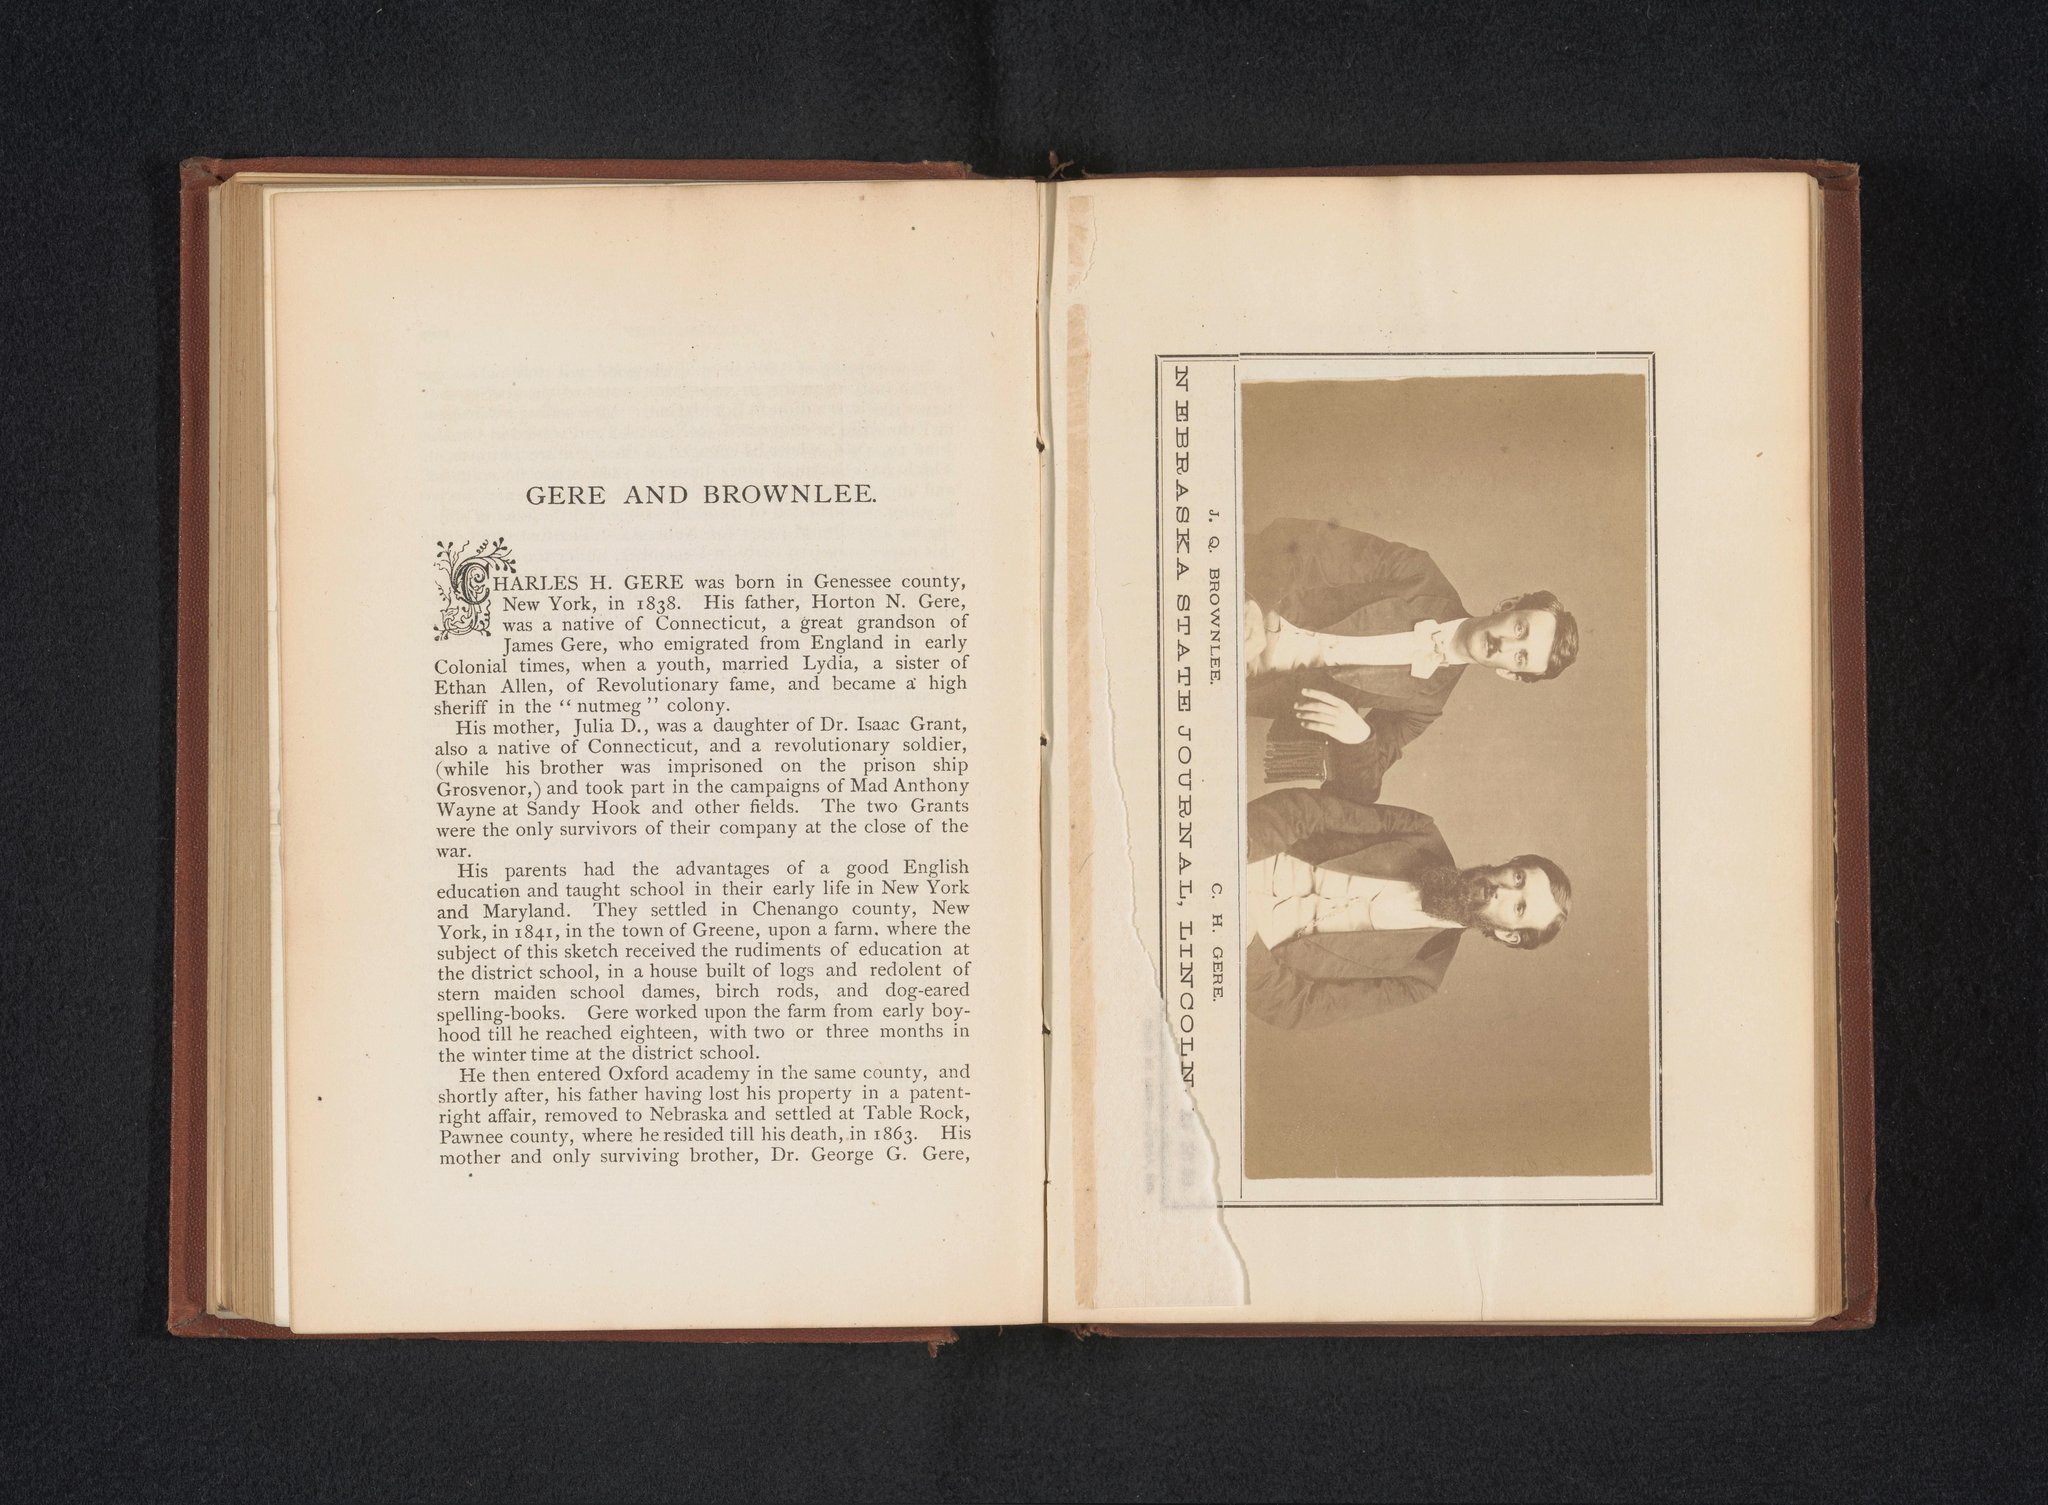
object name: photograph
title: Portret van Charles H. Gere en John Q. Brownlee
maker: d.a. cline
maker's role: fotograaf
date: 1866-1871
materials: photographic support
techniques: albumen print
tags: new york, historical persons, politician, e.g. party leader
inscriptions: inscription: ‘Nebraska state journal, Lincoln, Neb.’